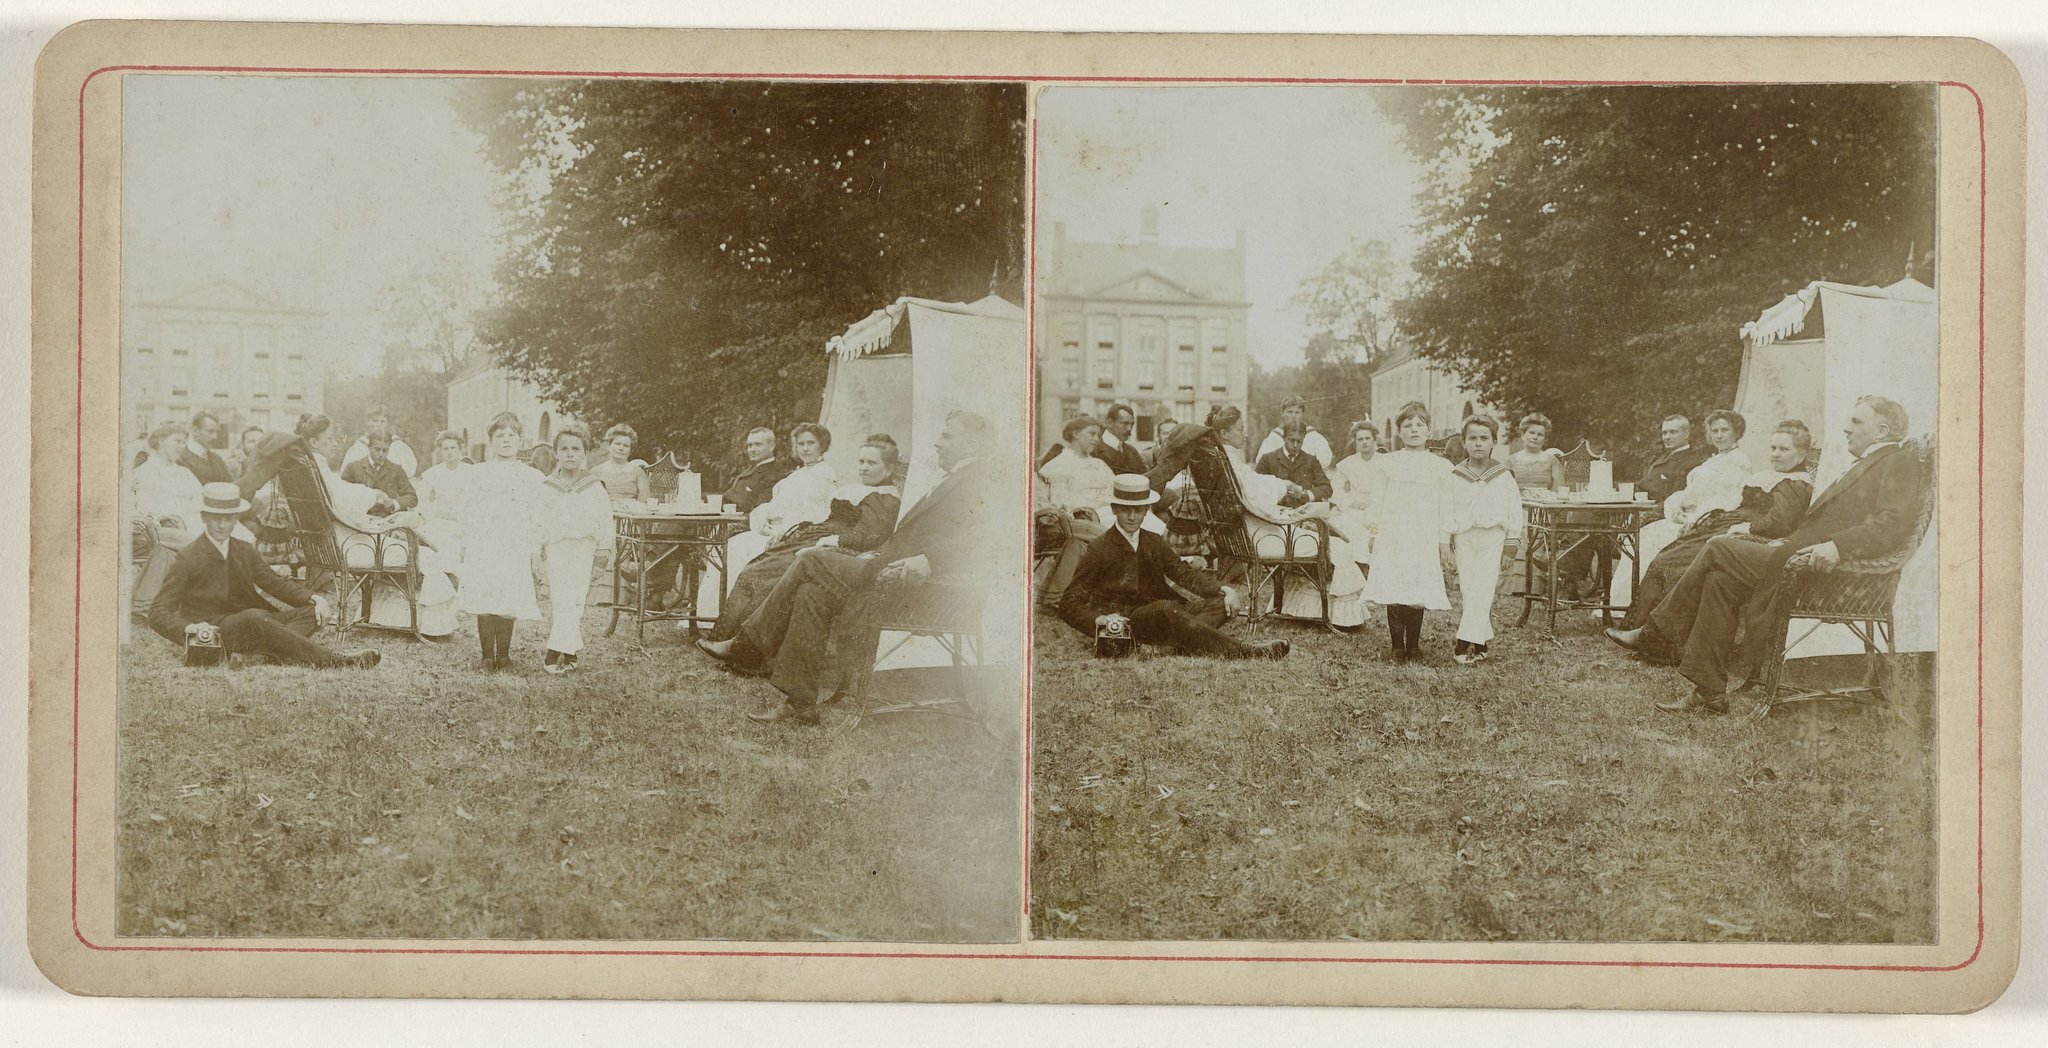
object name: stereograph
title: Theegroep bij mama's verjaardag, 7 Aug. 1904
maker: geldolph adriaan kessler (dolph)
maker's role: fotograaf, industrieel, voetballer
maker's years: 1884-1945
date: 1904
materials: paper, photographic support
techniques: collodion silver print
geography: veluwe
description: Groepsportret van familie Kessler-de Lange voor landhuis Ter Horst op de Veluwe met links op voorgrond jongeman met fotocamera.